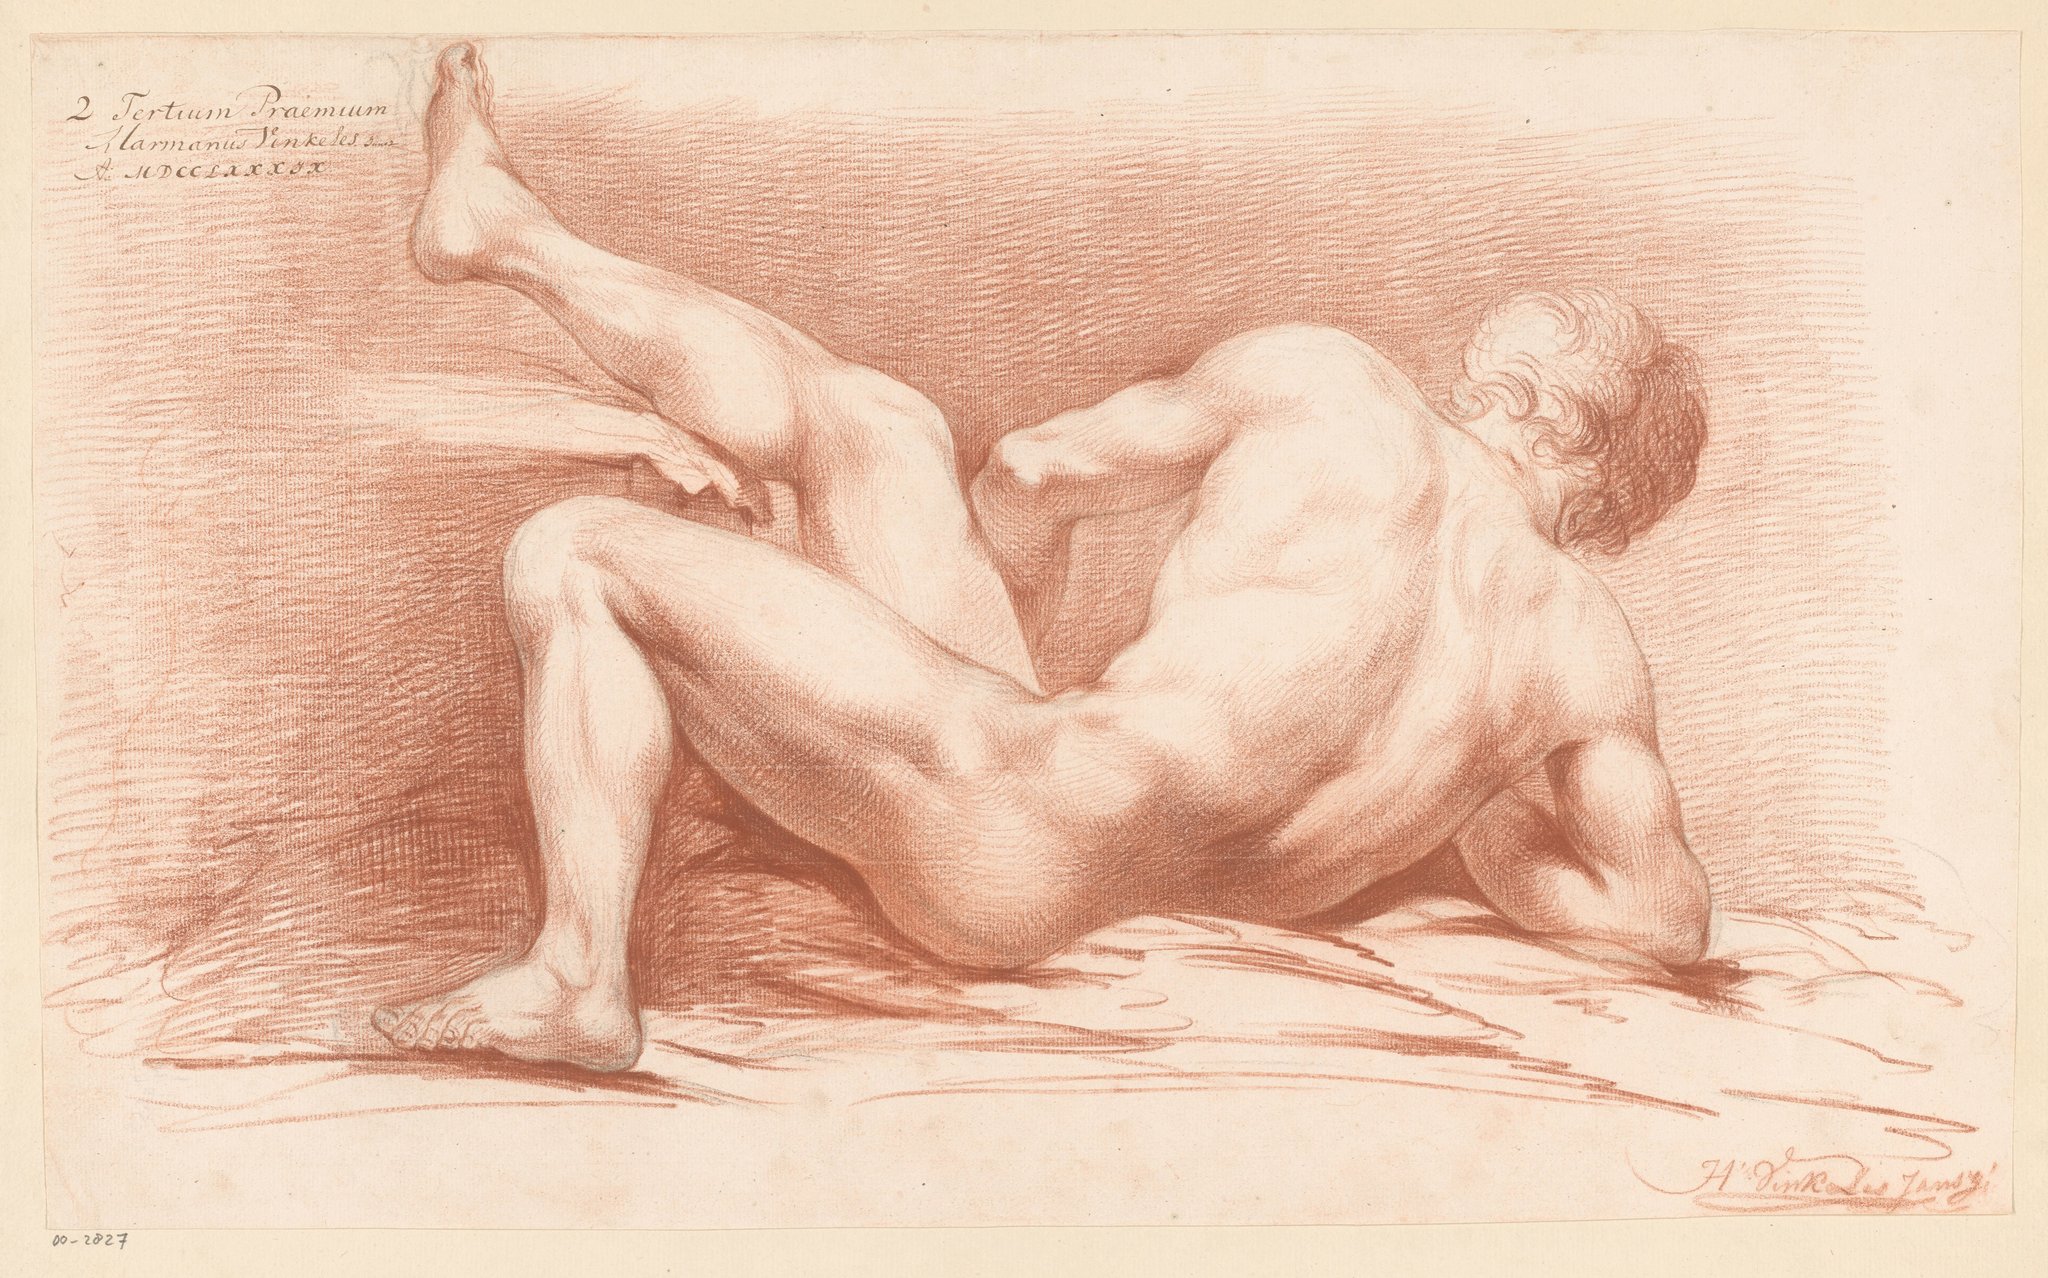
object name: drawing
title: Zittend mannelijk naakt, op de rug gezien (3e prijs 1789)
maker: harmanus jansz. vinkeles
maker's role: draughtsman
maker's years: 1768-1846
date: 1789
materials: chalk, charcoal, paper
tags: sitting figure (+ nude human being)